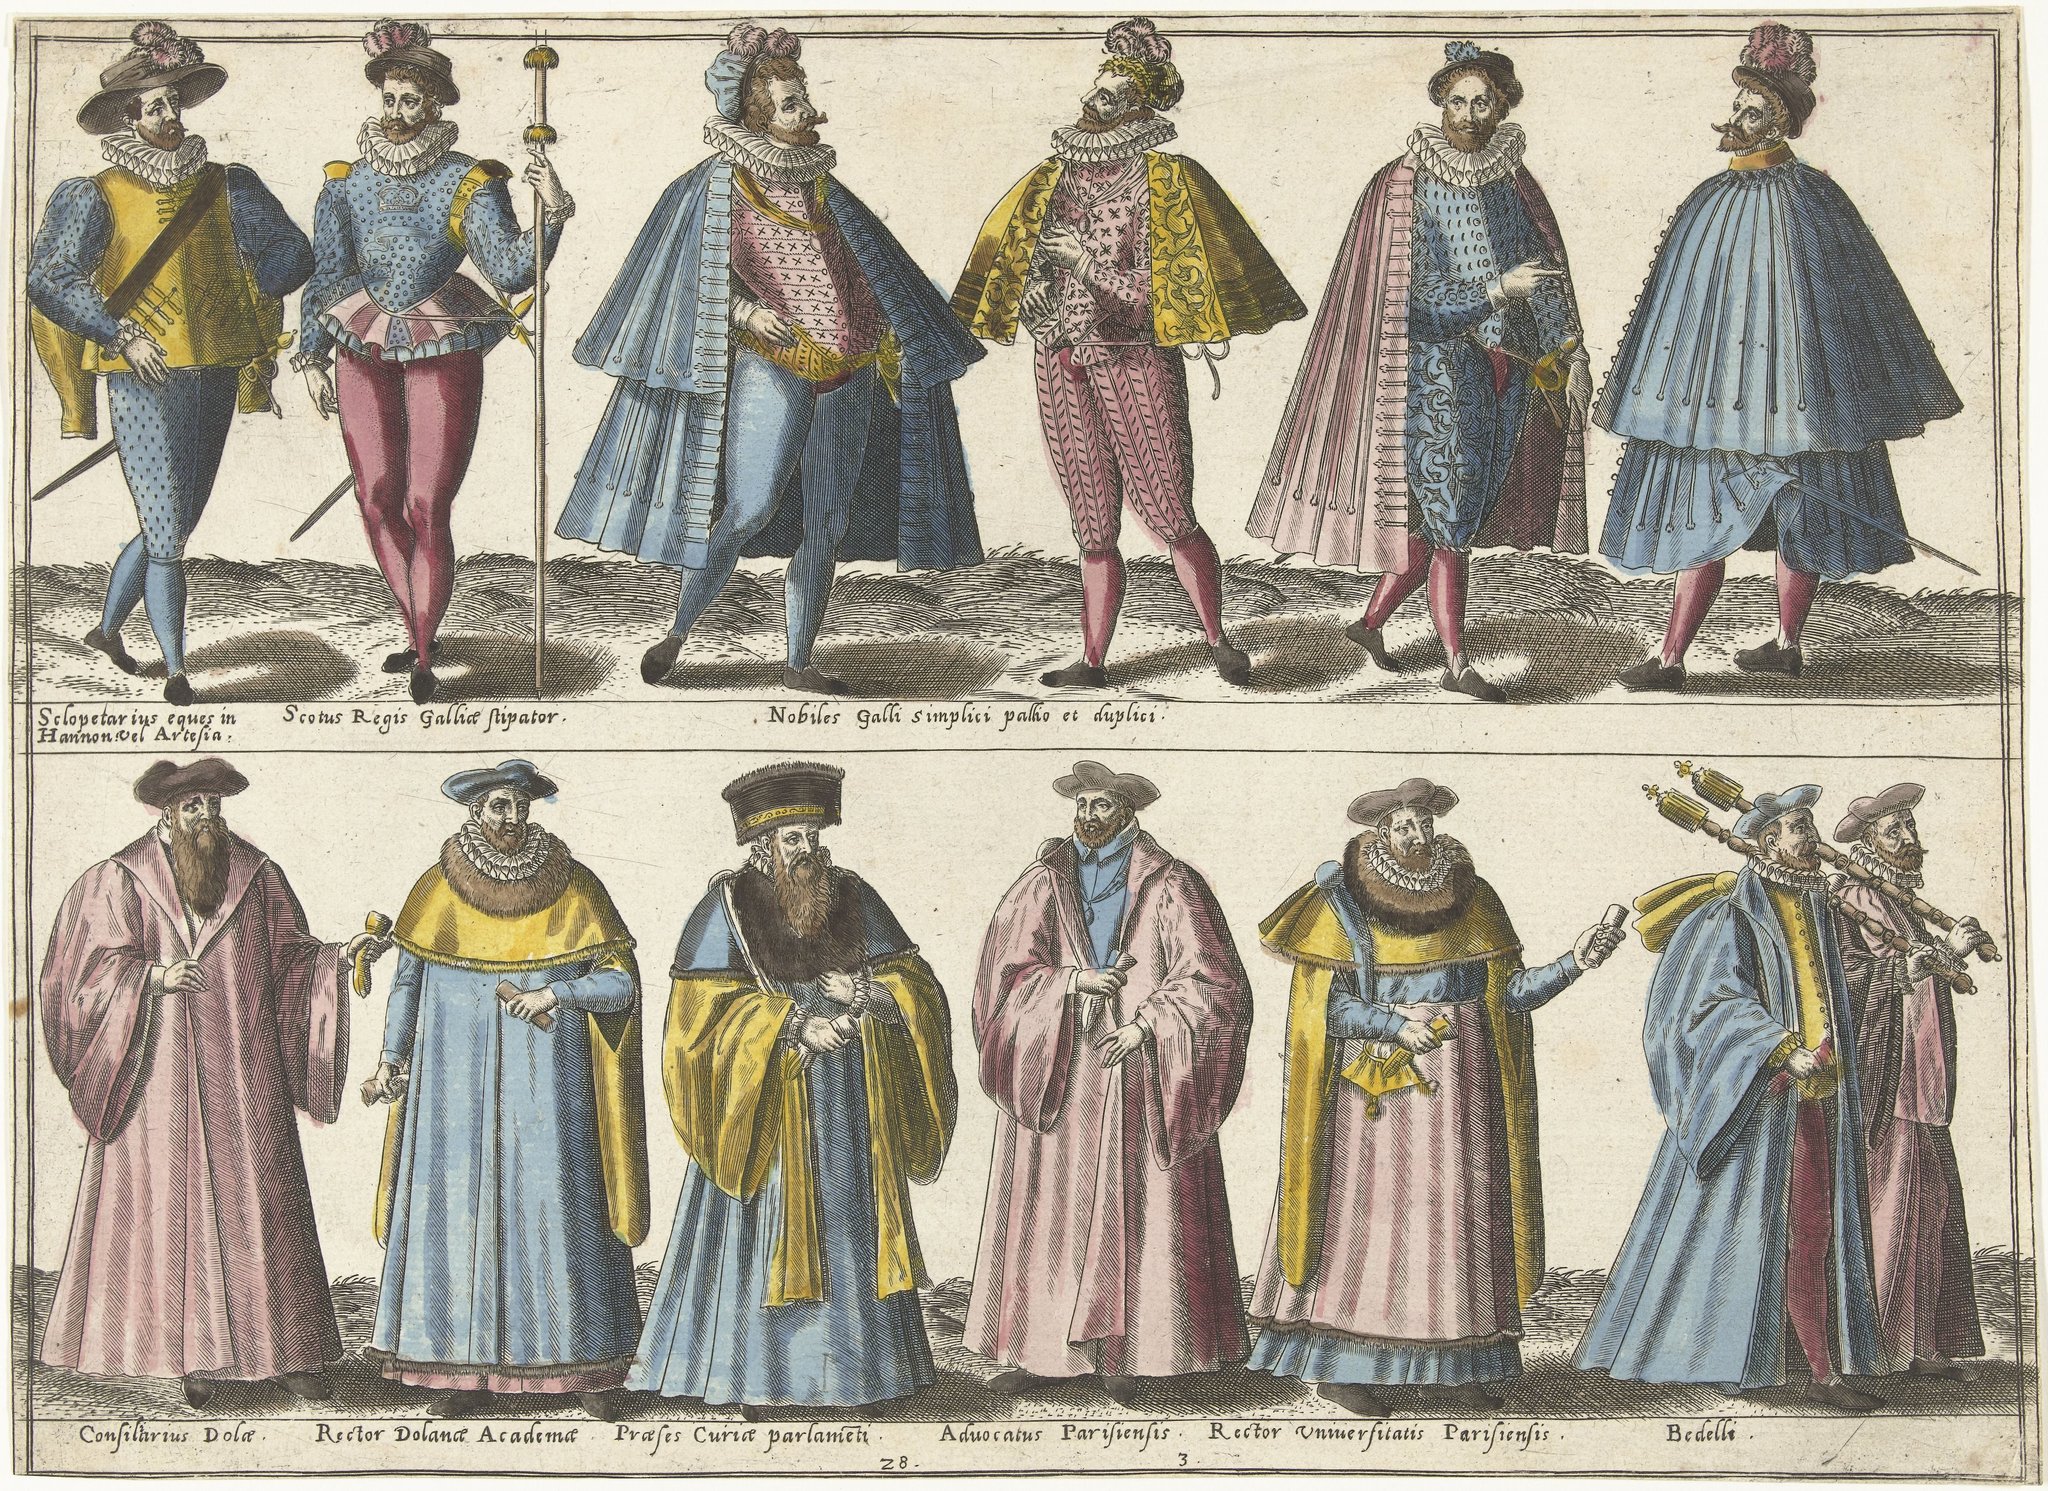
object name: book illustration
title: Kleding van verschillende standen volgens de Franse mode rond 1580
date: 1581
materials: paper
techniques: engraving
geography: antwerp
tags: europeans (with name) (+ costume), professional clothes, coat (+ men's clothes), clothes, costume (+ men's clothes)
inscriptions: collector's mark: Lugt 2228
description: Prent uit een boek over kleding rond 1580. In twee rijen boven elkaar herenkleding afgebeeld. In de bovenste rij adellijke heren en twee Franse hofwachters. In de onderste rij heren in ambtskleding. Van Links naar rechts: een raadgever, een rector, een Parijse advocaat, een Parijse rector, etc. Prent oorspronkelijk uit het boek 'Omnium pene Europae, Asiae, Aphricae atque Americae gentium habitus...', 1581.